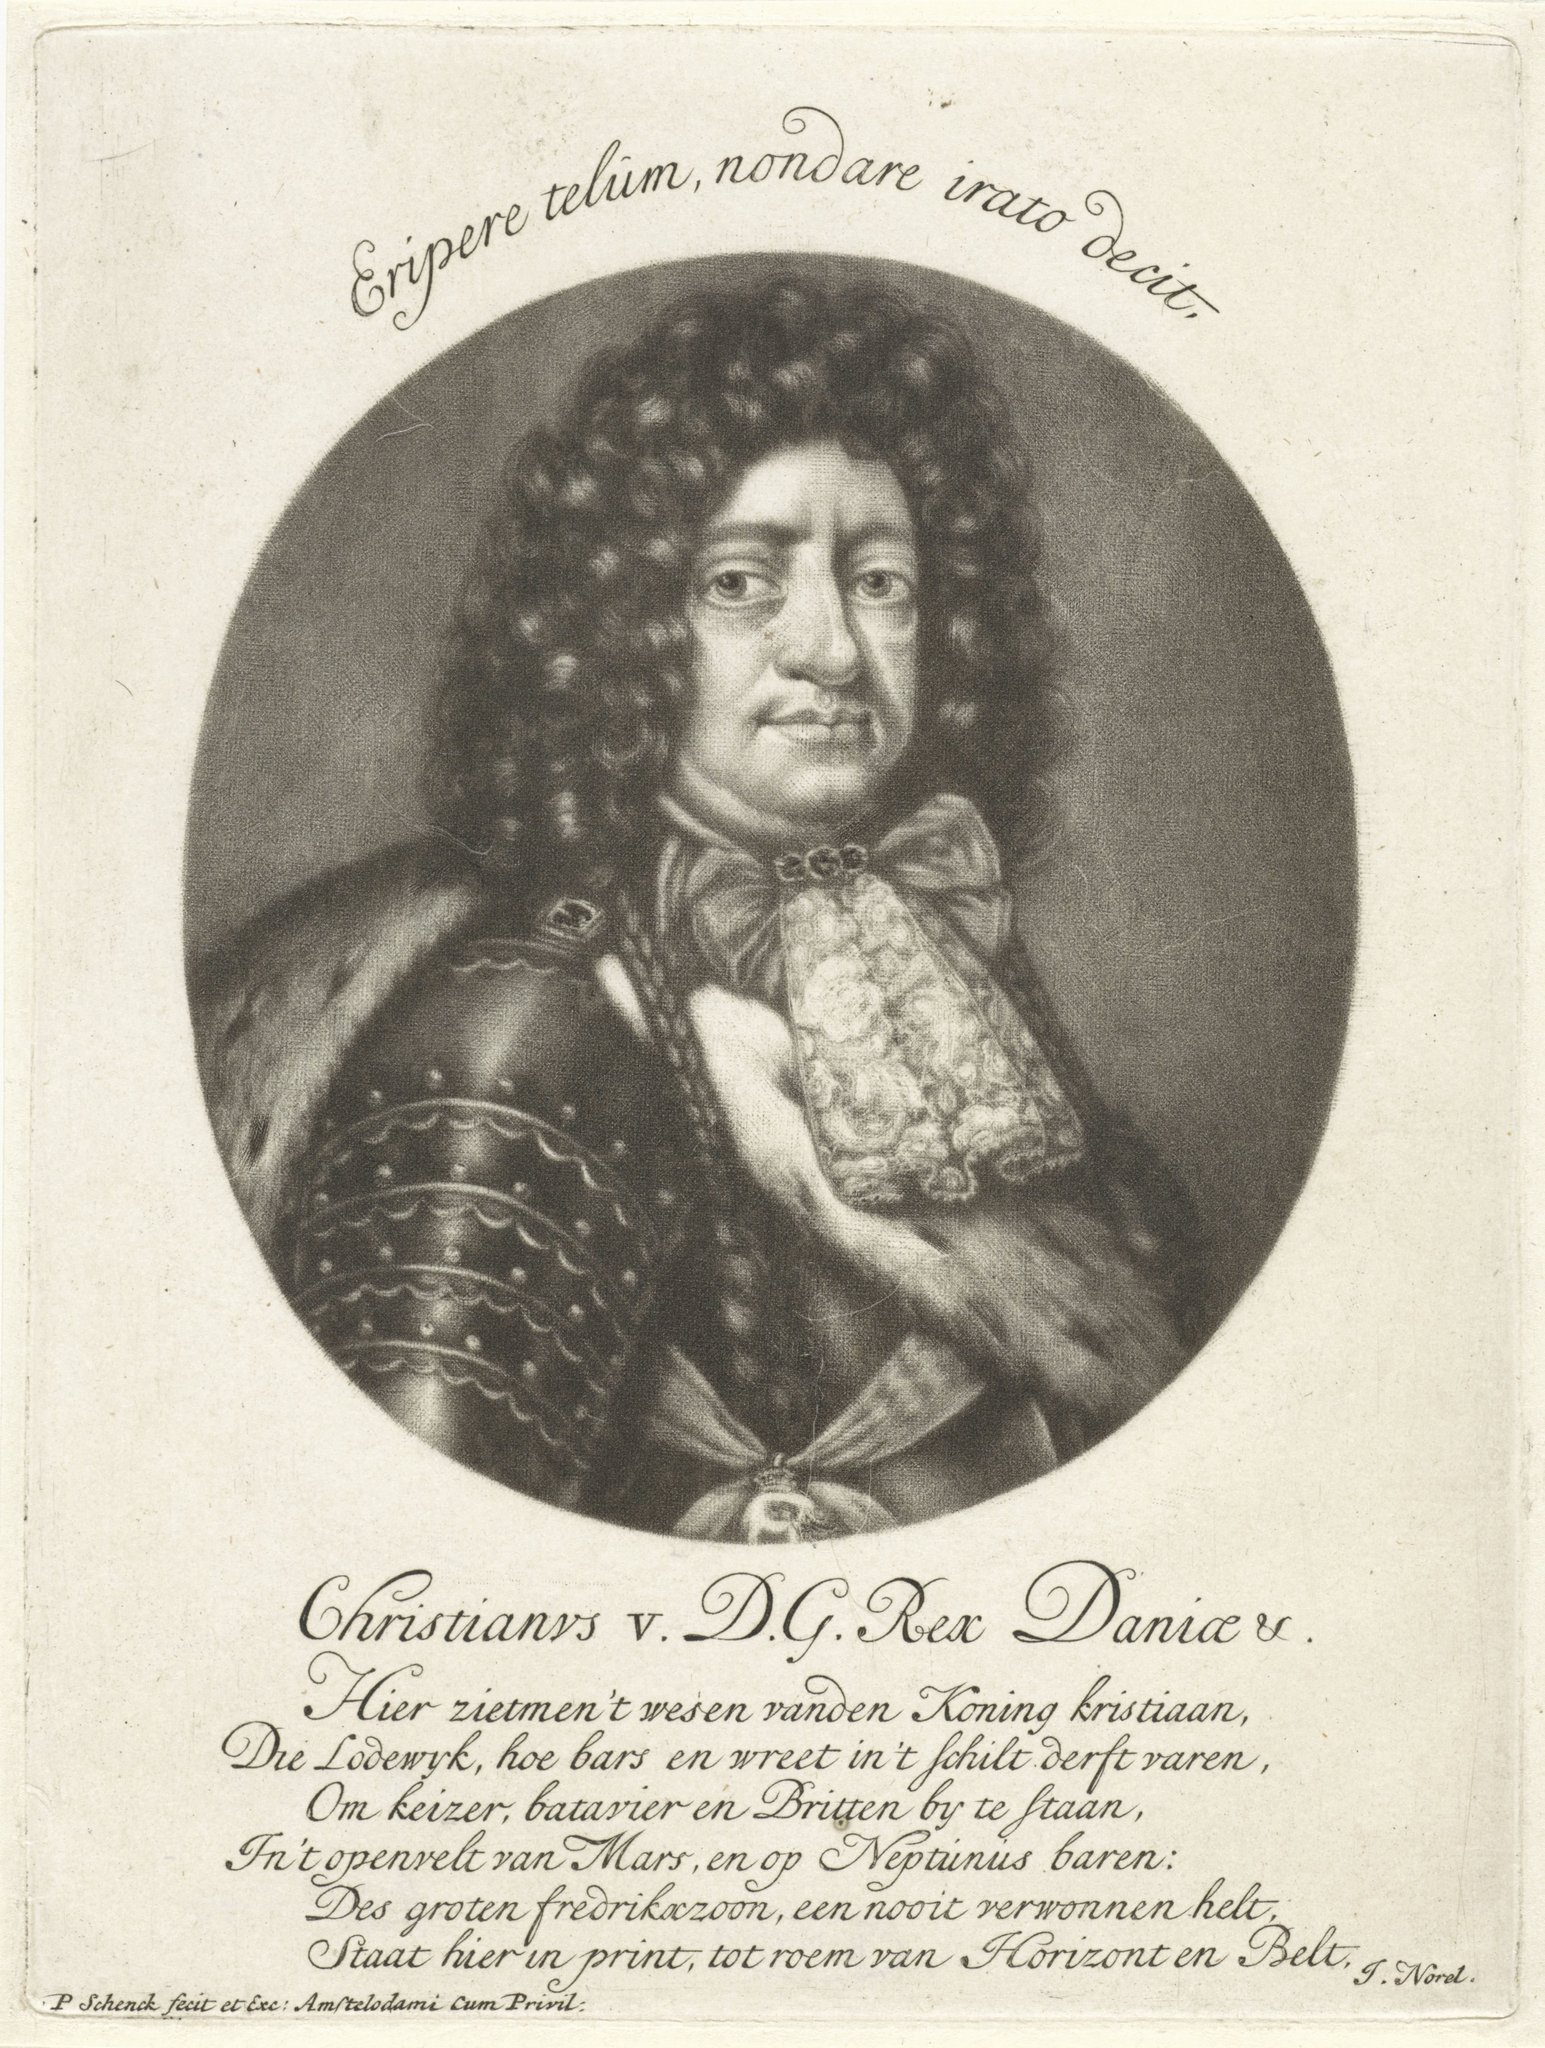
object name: print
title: Portret van Christiaan V, koning van Denemarken en Noorwegen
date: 1670-1713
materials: paper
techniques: engraving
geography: amsterdam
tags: flensburg, christiaan v (koning van denemarken en noorwegen)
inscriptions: collector's mark: Lugt 2228